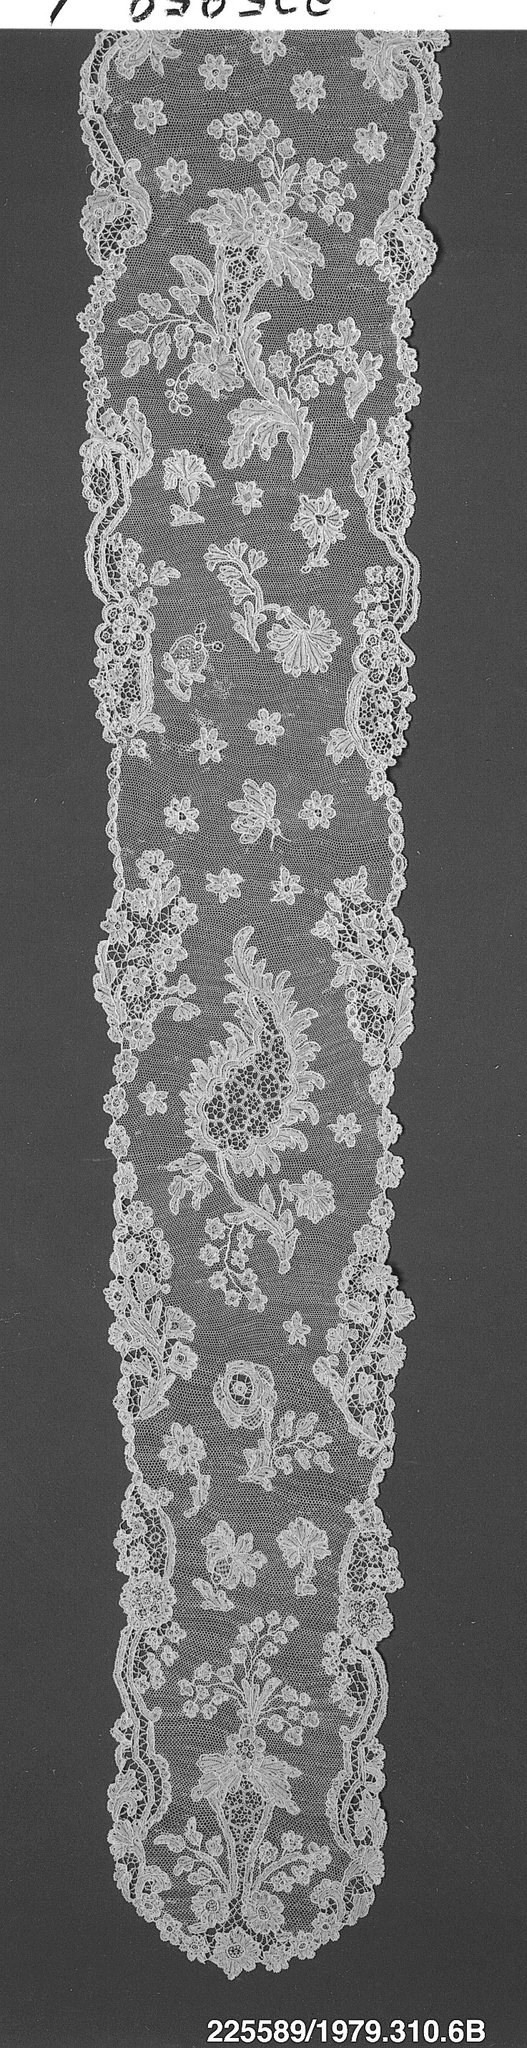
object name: lappet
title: Joined lappets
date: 1751-1775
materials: linen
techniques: lace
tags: flowers